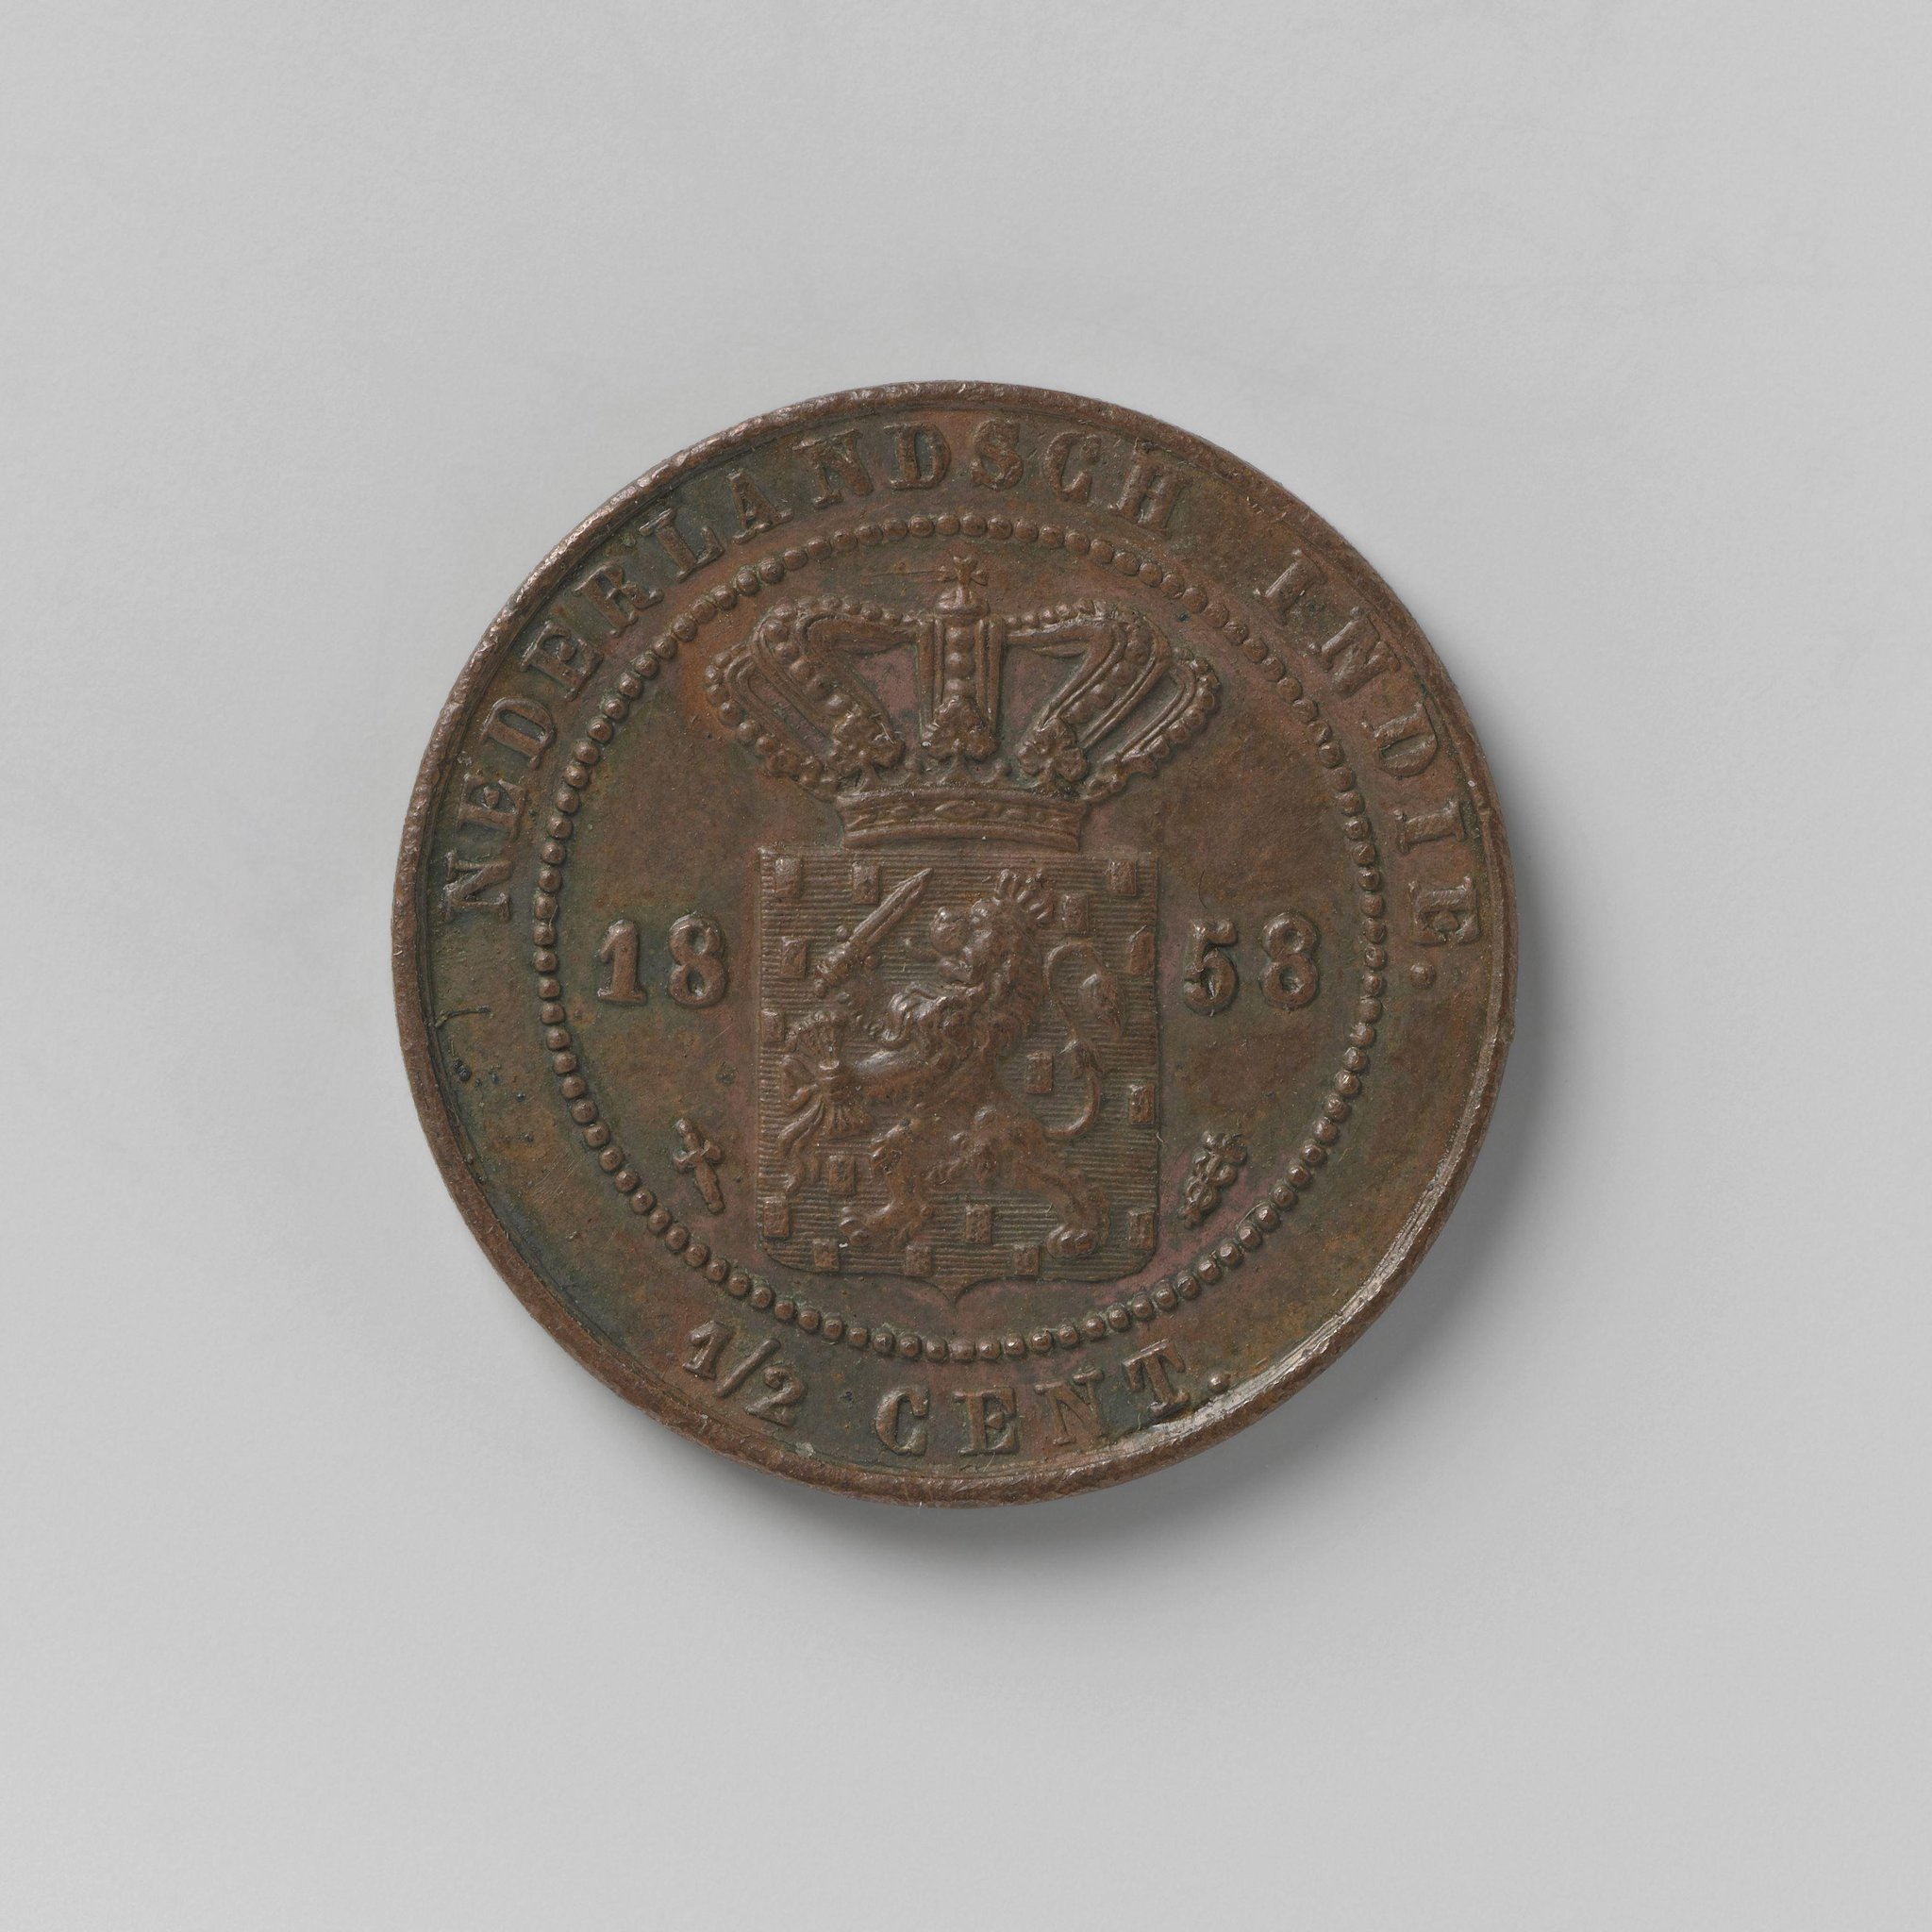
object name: coin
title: Nederlands Indië, ½ cent, 1858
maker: willem iii (koning der nederlanden)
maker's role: koning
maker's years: 1817-1890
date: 1858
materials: copper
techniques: striking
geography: utrecht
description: Koperen munt. Voorzijde: tussen jaartal gekroond rijkswapenschild. Boven kroon landsaanduiding en onder wapenschild waarde-aanduiding. Keerzijde: drieregelig Maleis opschrift in Arabische tekens, waaromheen omschrift in het Javaans. Gladde rand.